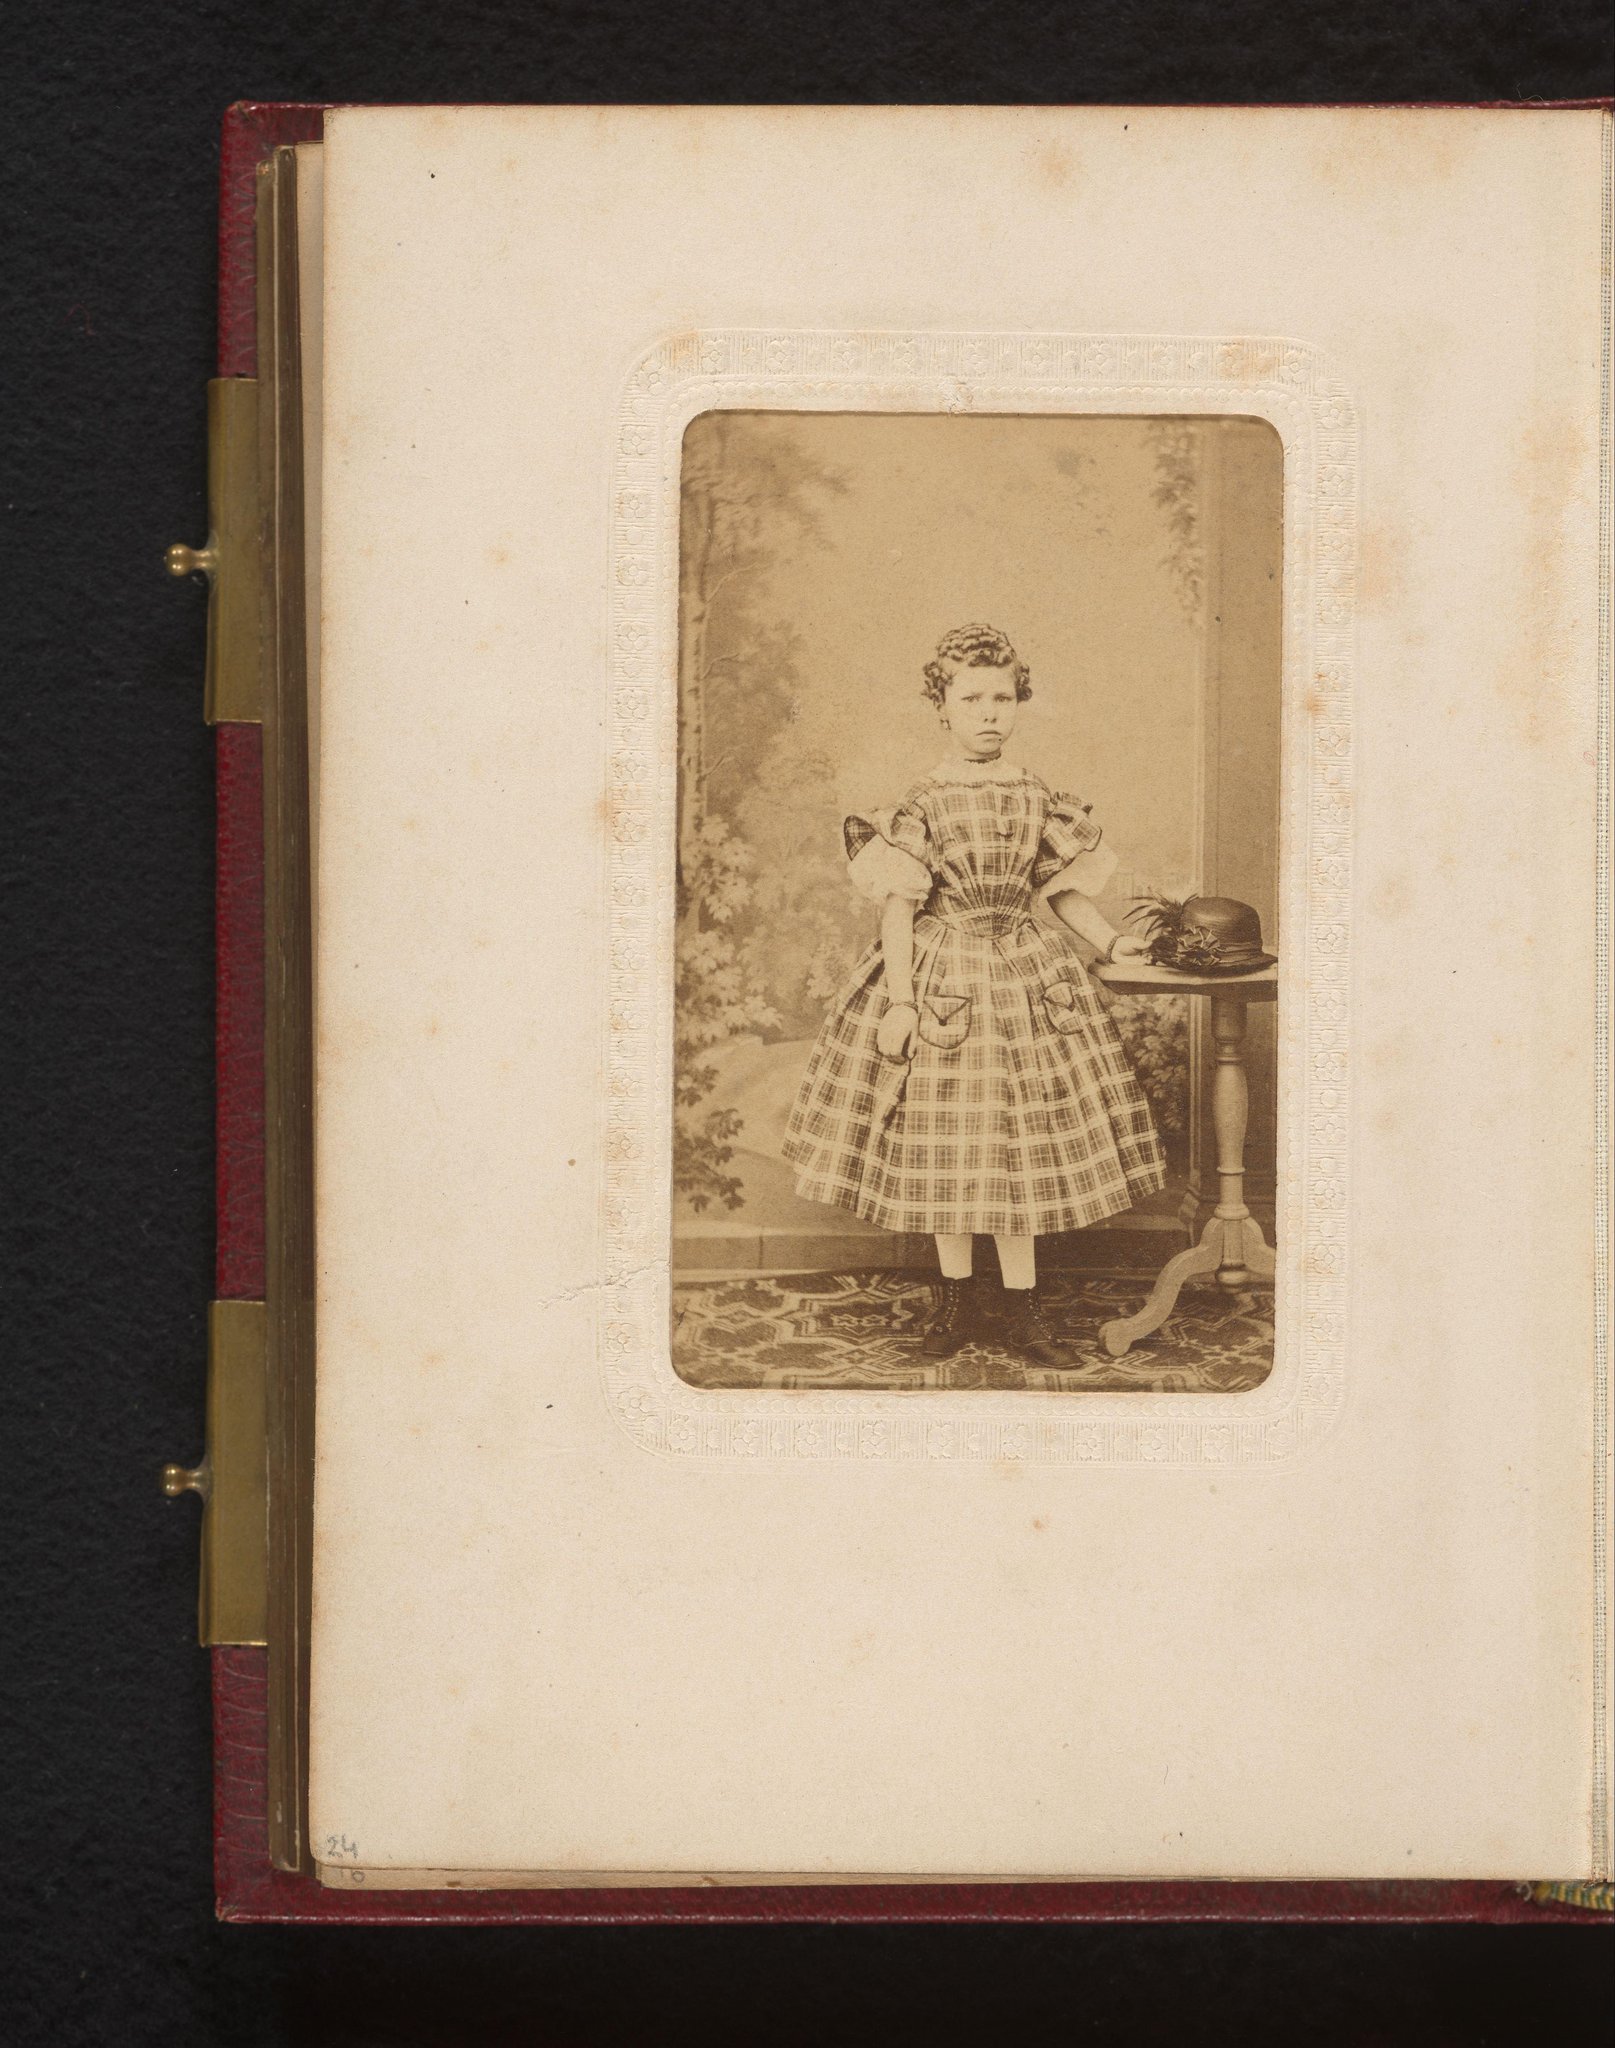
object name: carte de visite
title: Portret van een meisje, staand bij een tafel met hoed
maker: Anonymous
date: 1850-1880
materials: cardboard, photographic support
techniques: albumen print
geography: netherlands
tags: historical persons - bb - woman, girl (child between toddler and youth), table, head-gear: hat